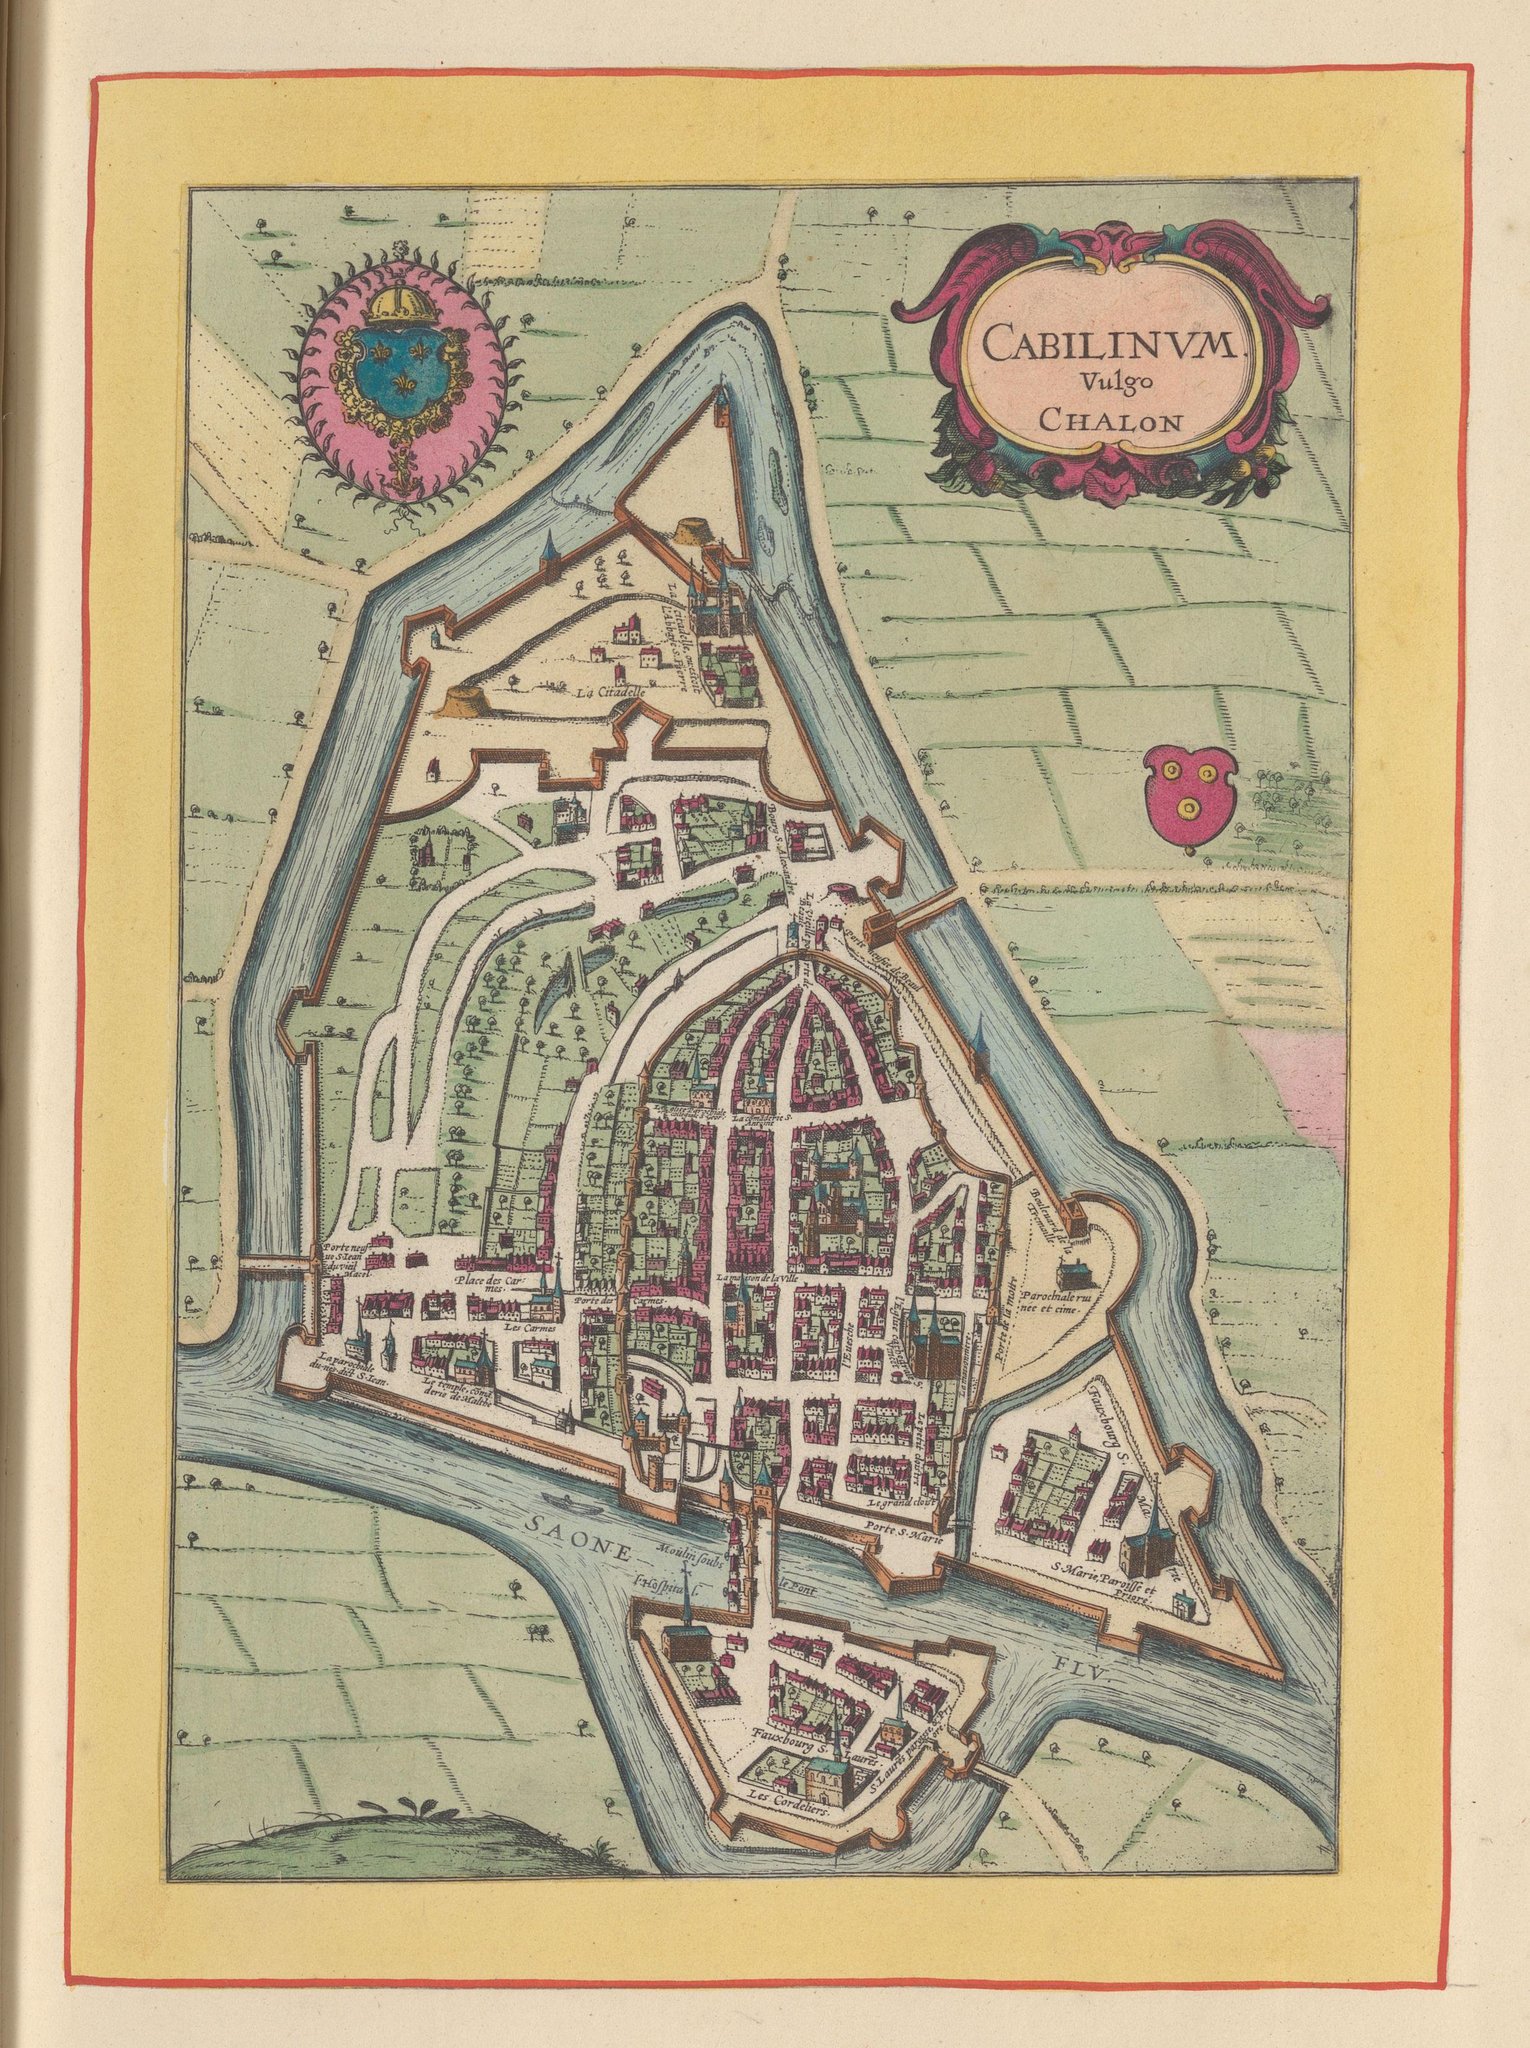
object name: album leaf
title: Plattegrond van Chalon-sur-Saône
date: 1657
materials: paper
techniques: engraving, hand coloring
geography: the hague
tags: maps of cities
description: Plattegrond uit: Theatrum exhibens celebriores Galliae et Helvetae urbes. Amsterdam: Johannes Janssonius, 1657.